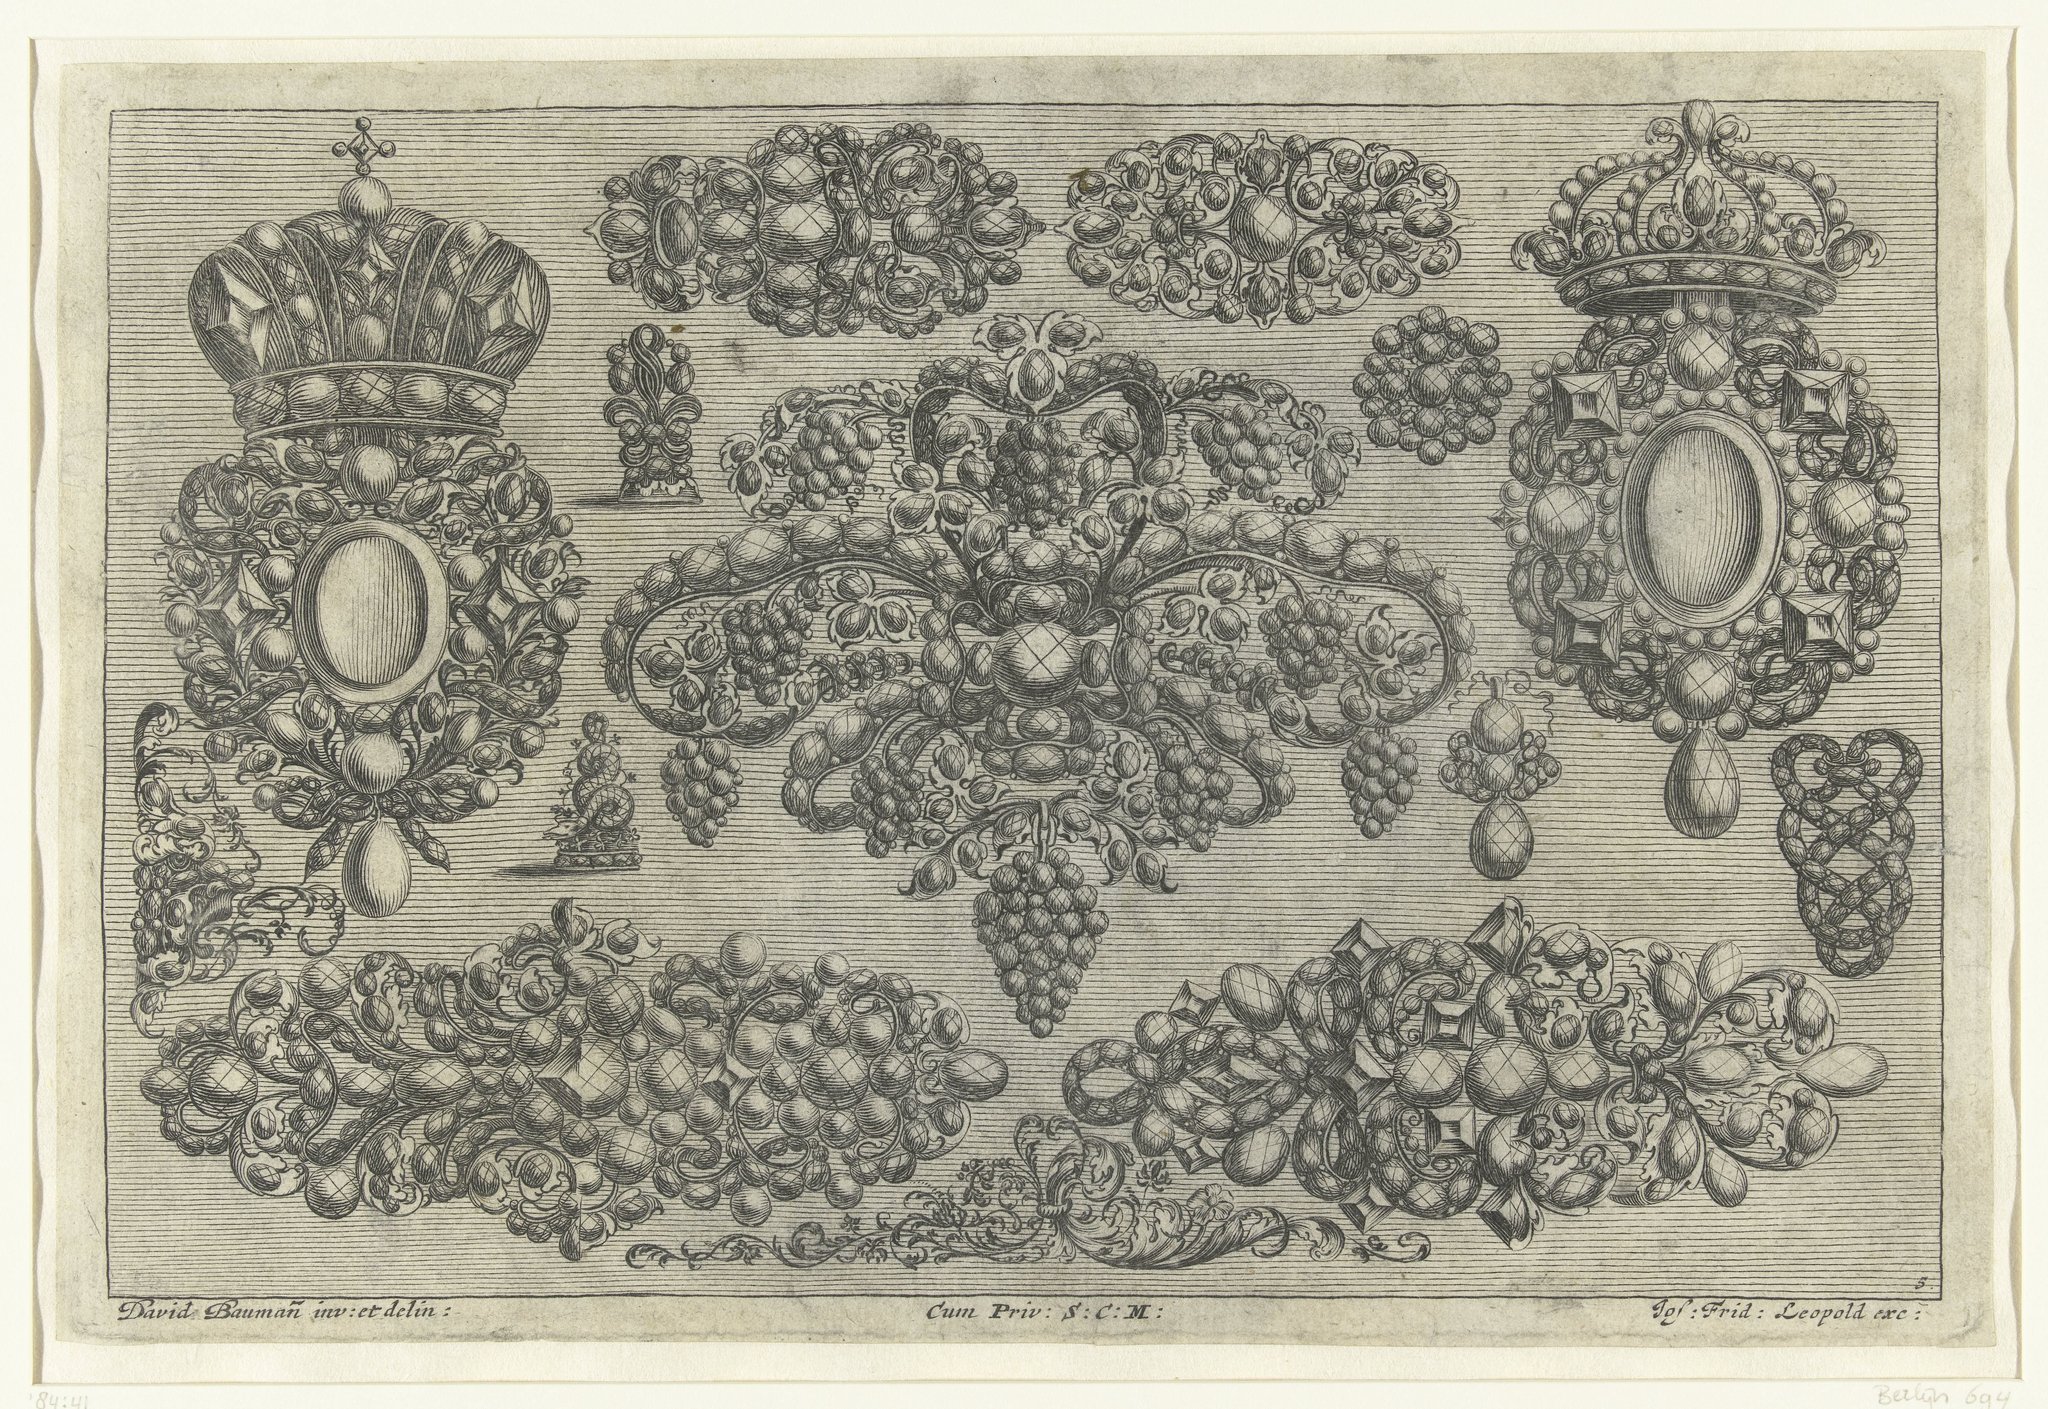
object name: print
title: Dertien ontwerpen voor juwelen en een bladrank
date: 1695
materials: paper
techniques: engraving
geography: germany